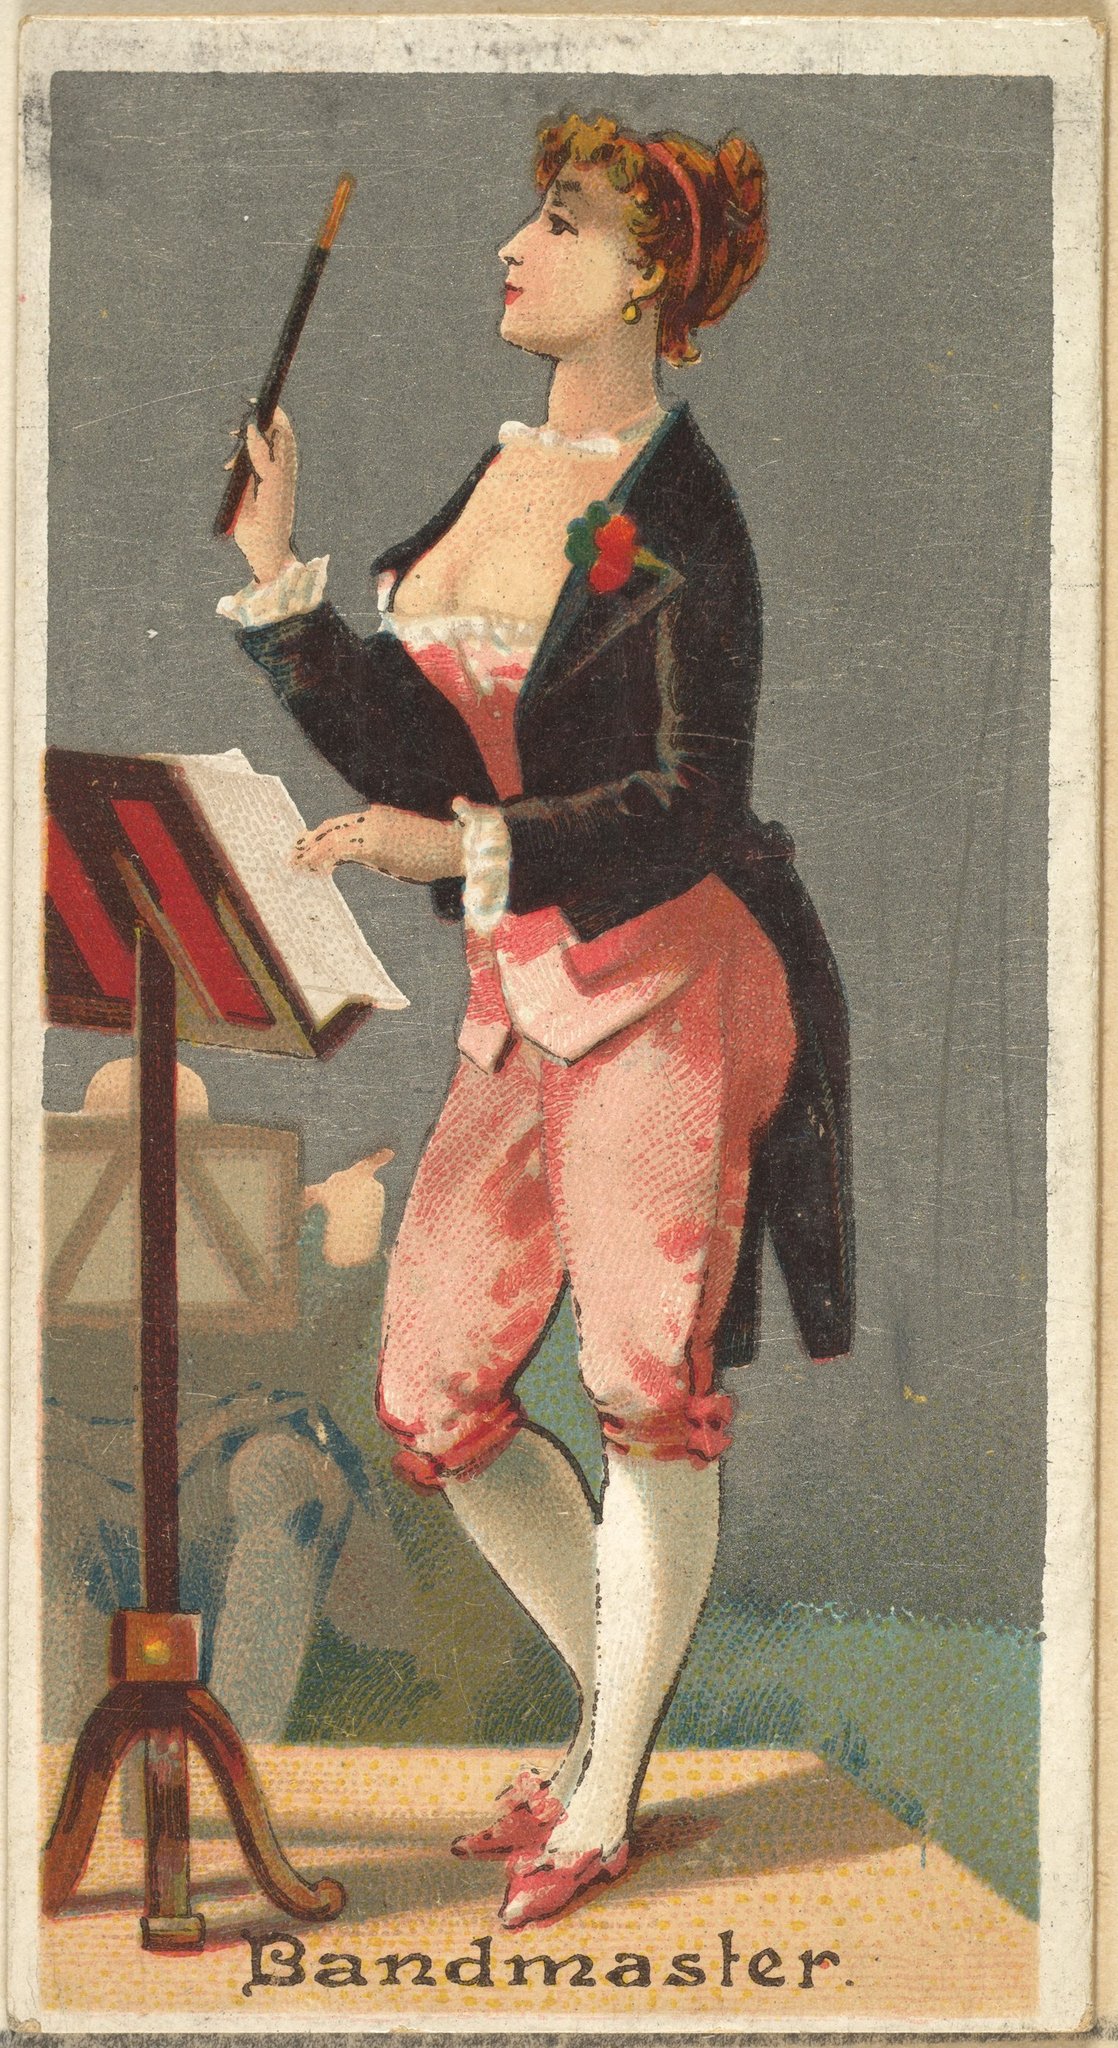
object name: print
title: Bandmaster, from the Occupations for Women series (N166) for Old Judge and Dogs Head Cigarettes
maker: goodwin & company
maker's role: publisher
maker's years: 1850-1950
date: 1887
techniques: color lithograph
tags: profiles,women,musicians